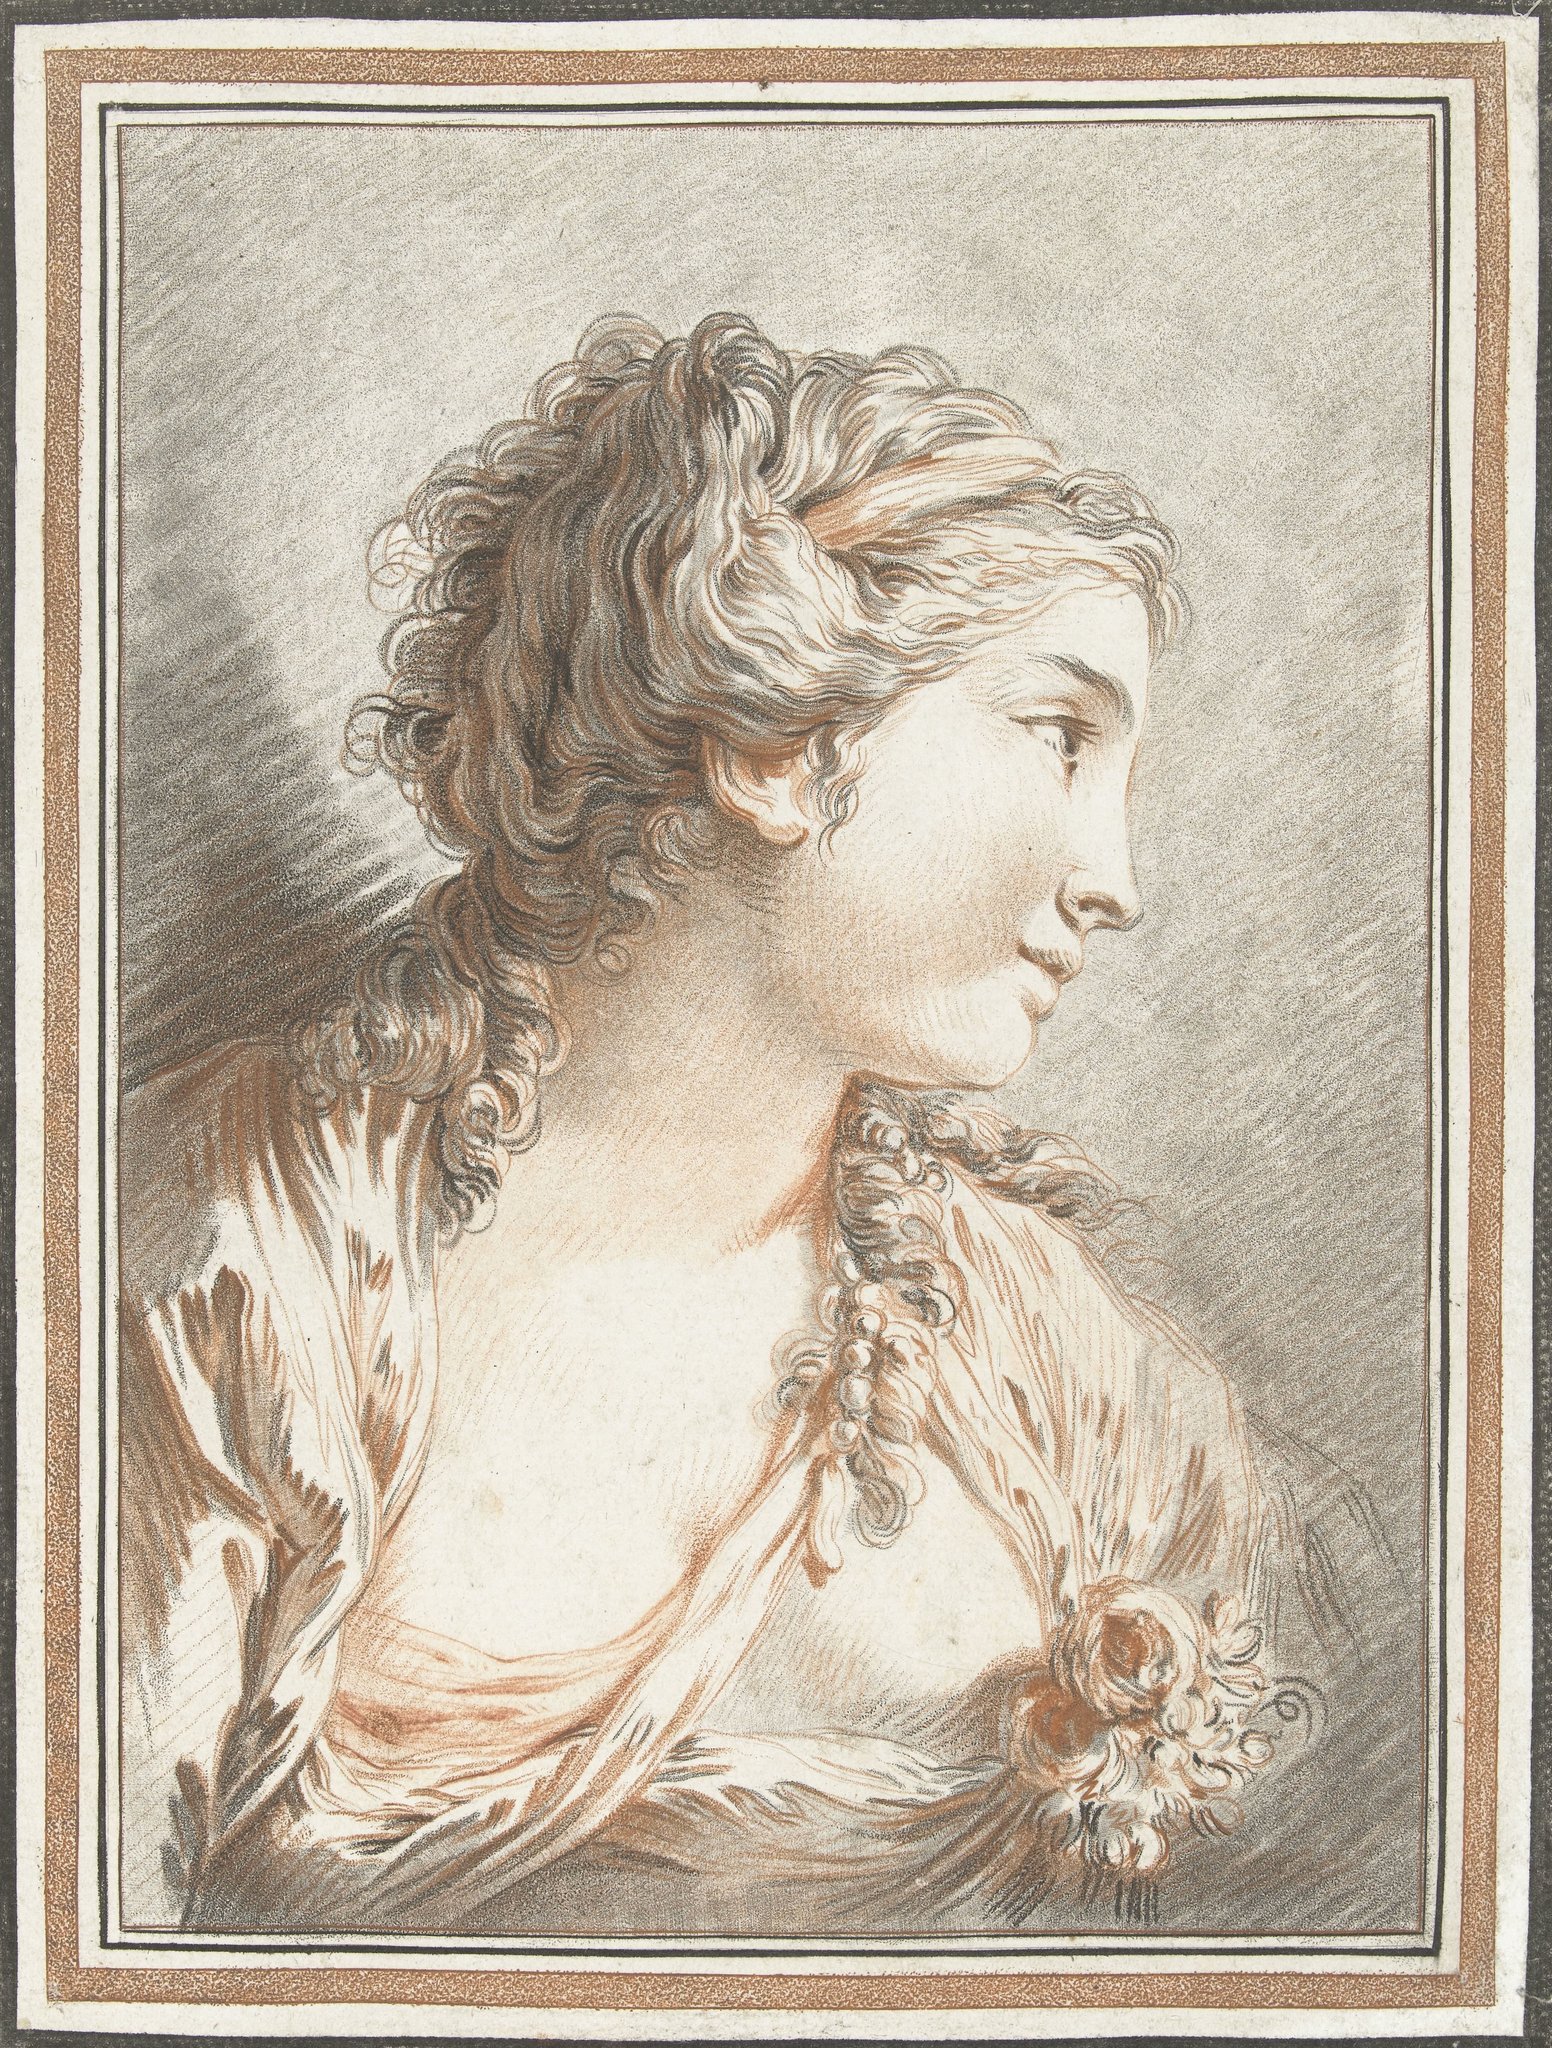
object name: print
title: Buste van vrouw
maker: gilles demarteau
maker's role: print maker, publisher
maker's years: 1722-1776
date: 1732-1776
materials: paper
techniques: printmaking, etching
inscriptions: collector's mark: Lugt 2760, collector's mark: Lugt 2228